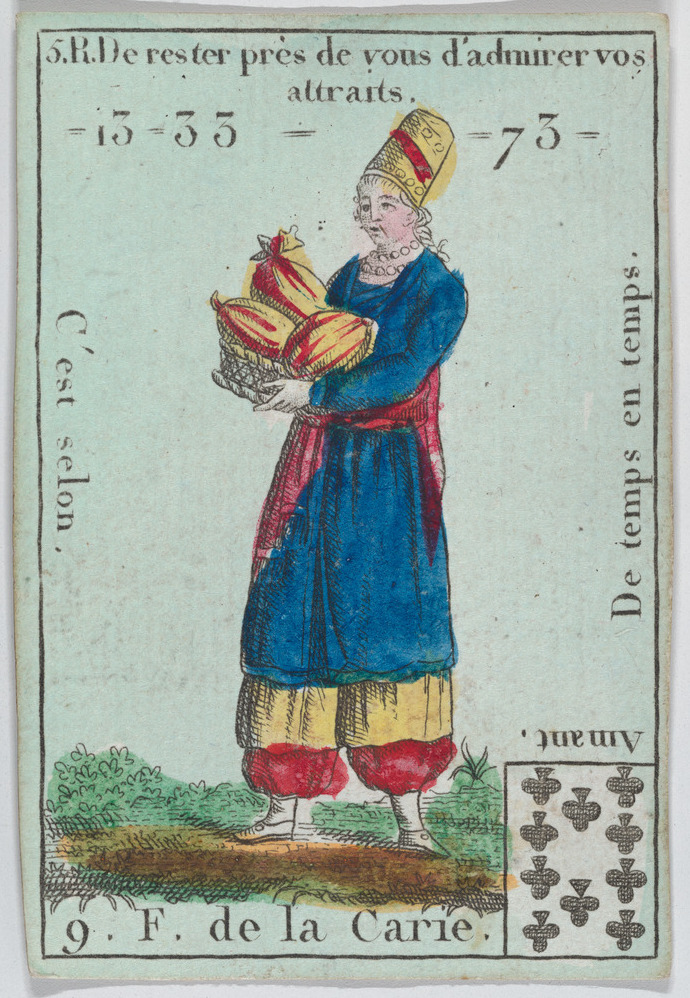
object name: print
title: F. de la Carie from playing cards "Jeu d'Or"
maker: anonymous, french, 18th century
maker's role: artist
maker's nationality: french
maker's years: 1700-1800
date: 1700-1799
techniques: etching, hand coloring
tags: portraits,women,playing cards